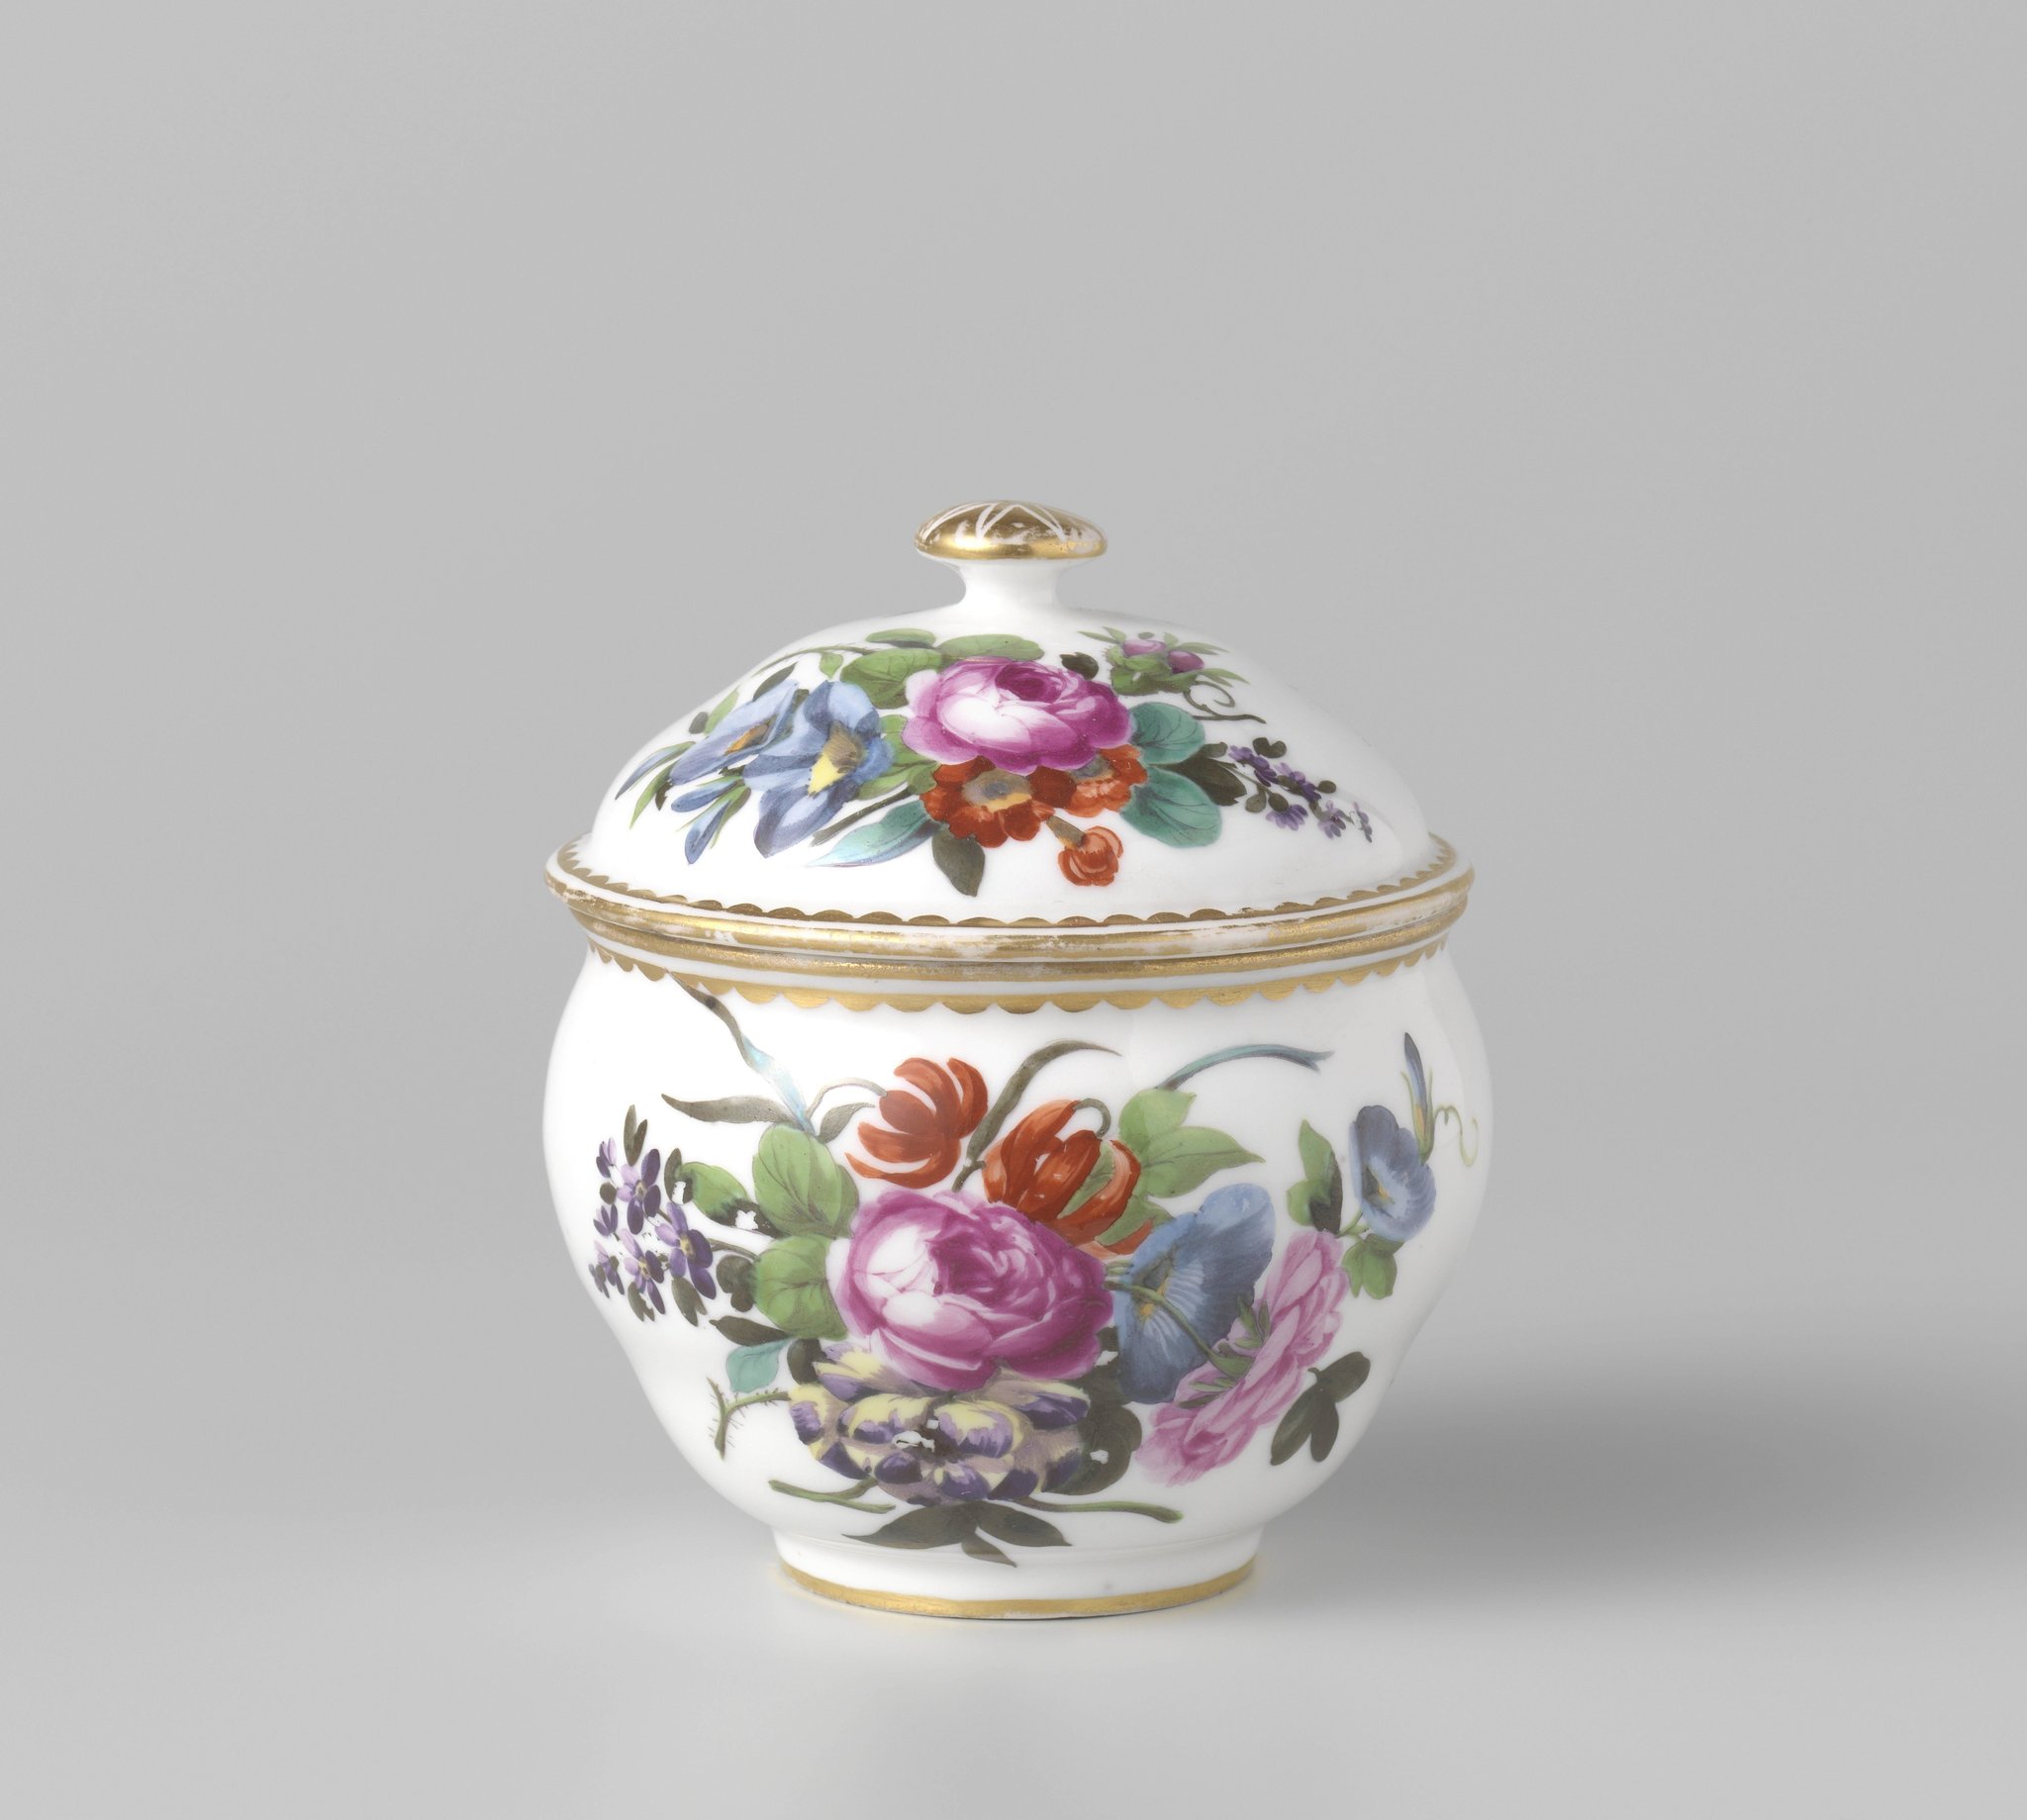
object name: sugar box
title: Tea service for two people (<tête-à-tête>)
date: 1778-1782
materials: porcelain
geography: loosdrecht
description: Manufactuur Oud-Loosdrecht Loosdrecht, c. 1778–1782 hard-paste porcelain